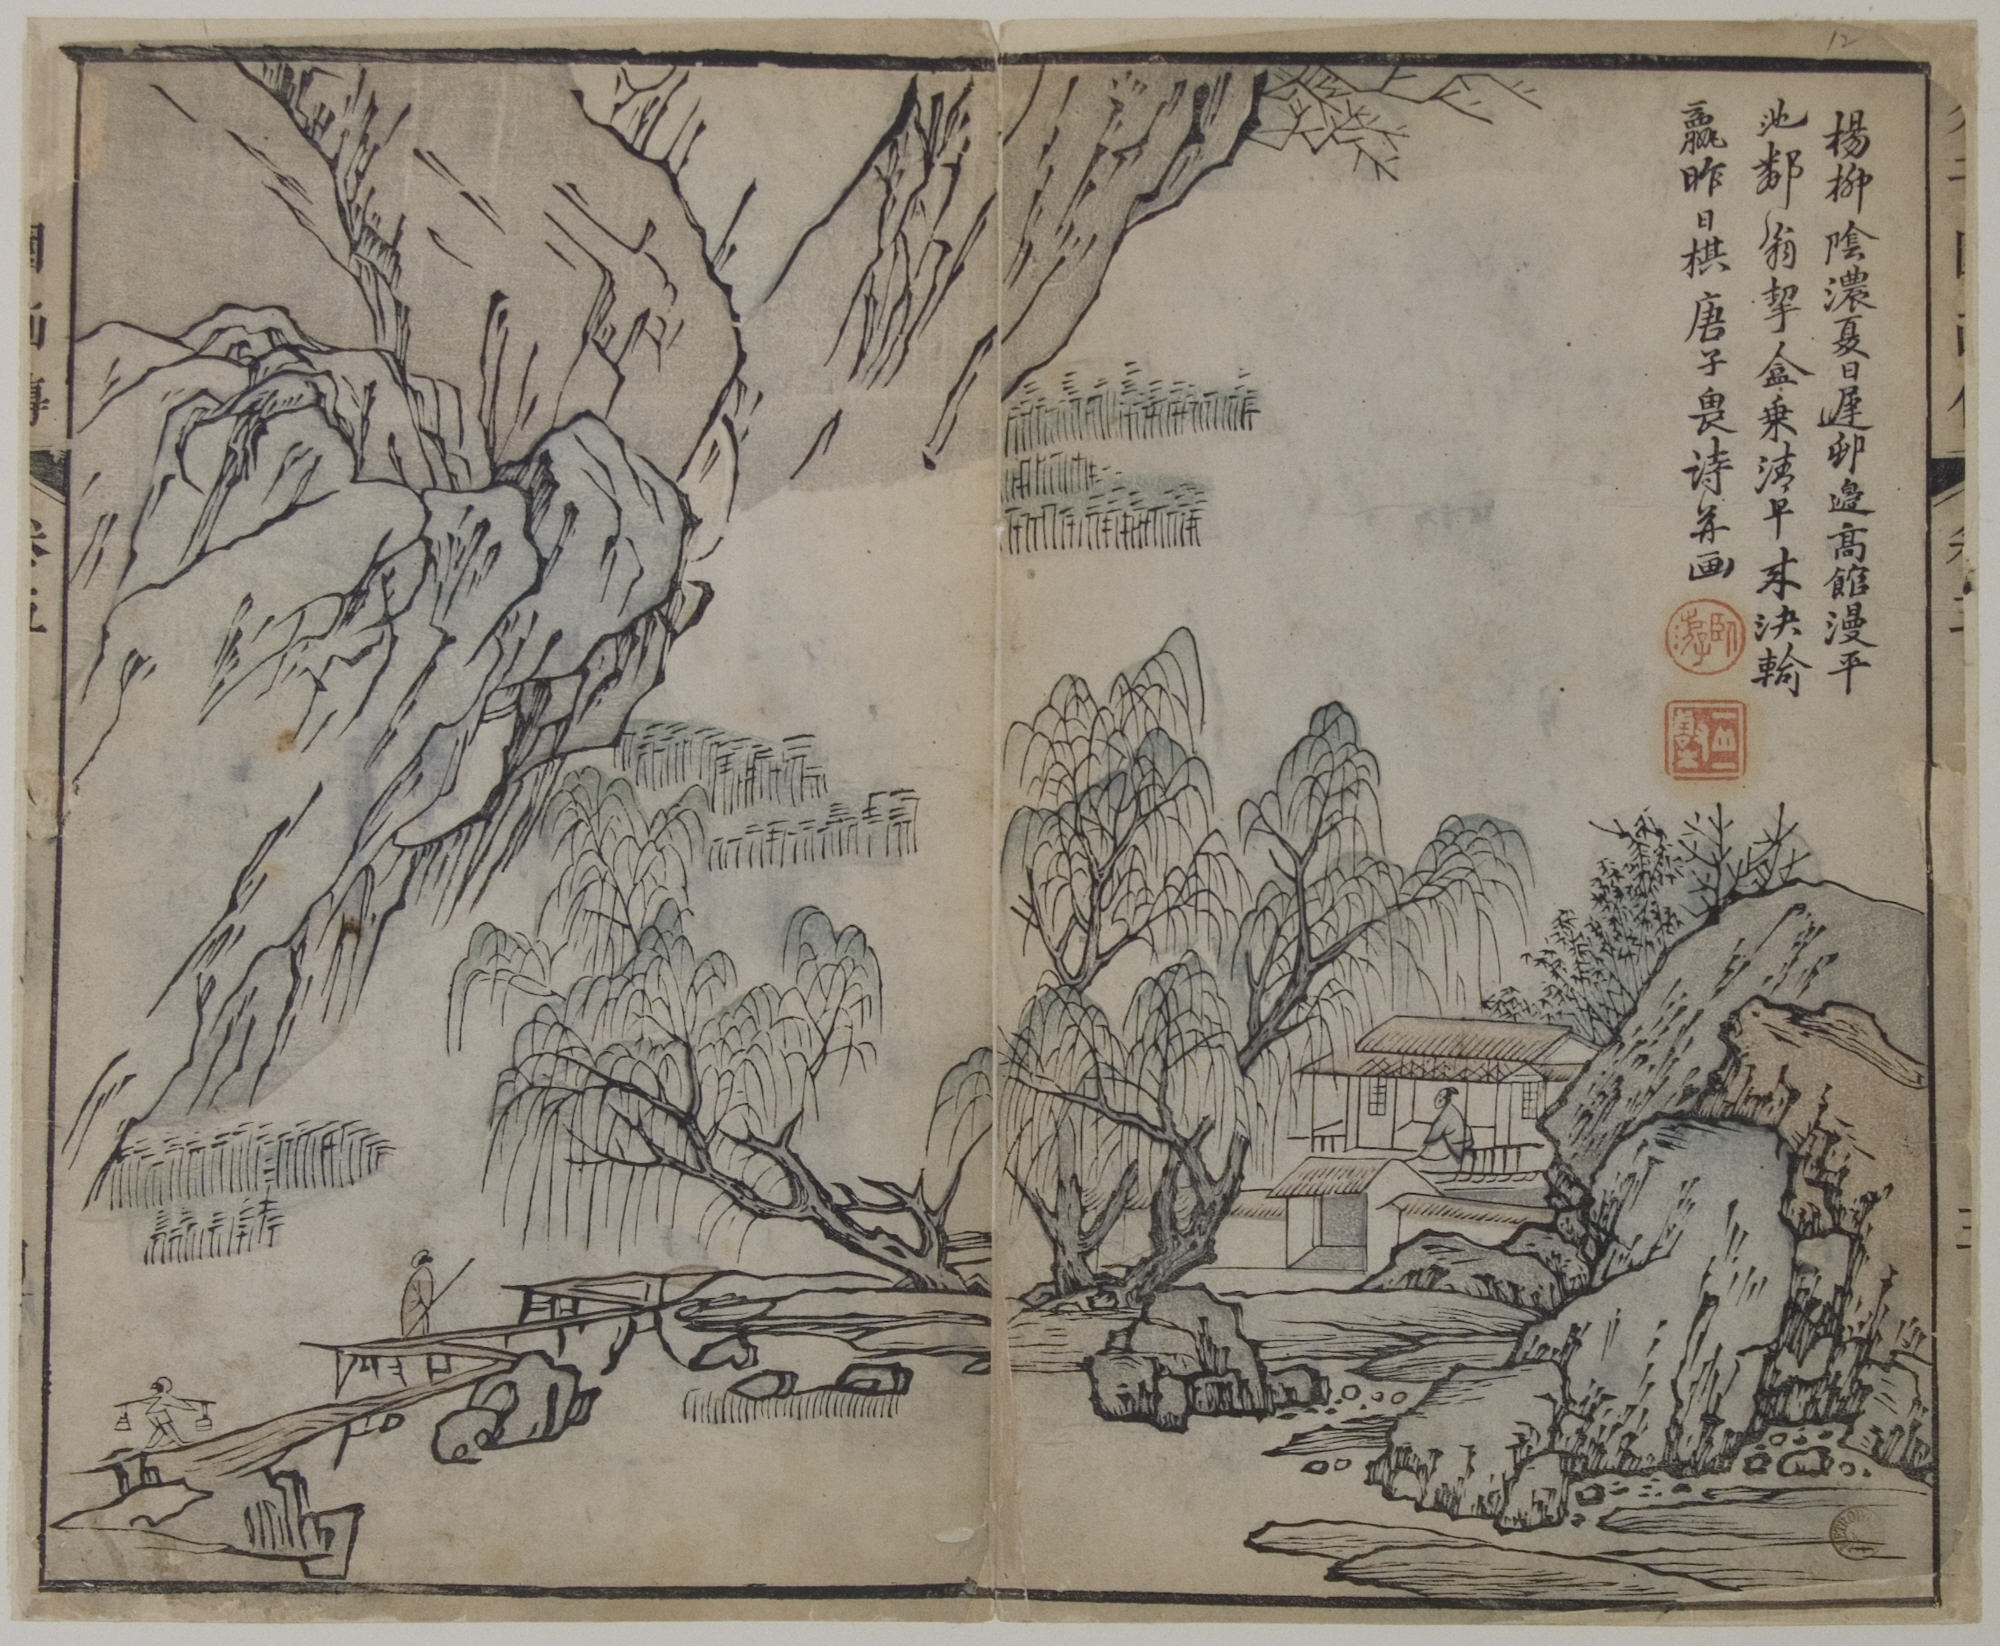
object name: print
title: Page from the Mustard Seed Garden Manual of Painting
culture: chinese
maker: wang gai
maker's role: artist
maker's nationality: chinese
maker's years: 1645-1710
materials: ink, paper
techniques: woodblock print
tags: trees